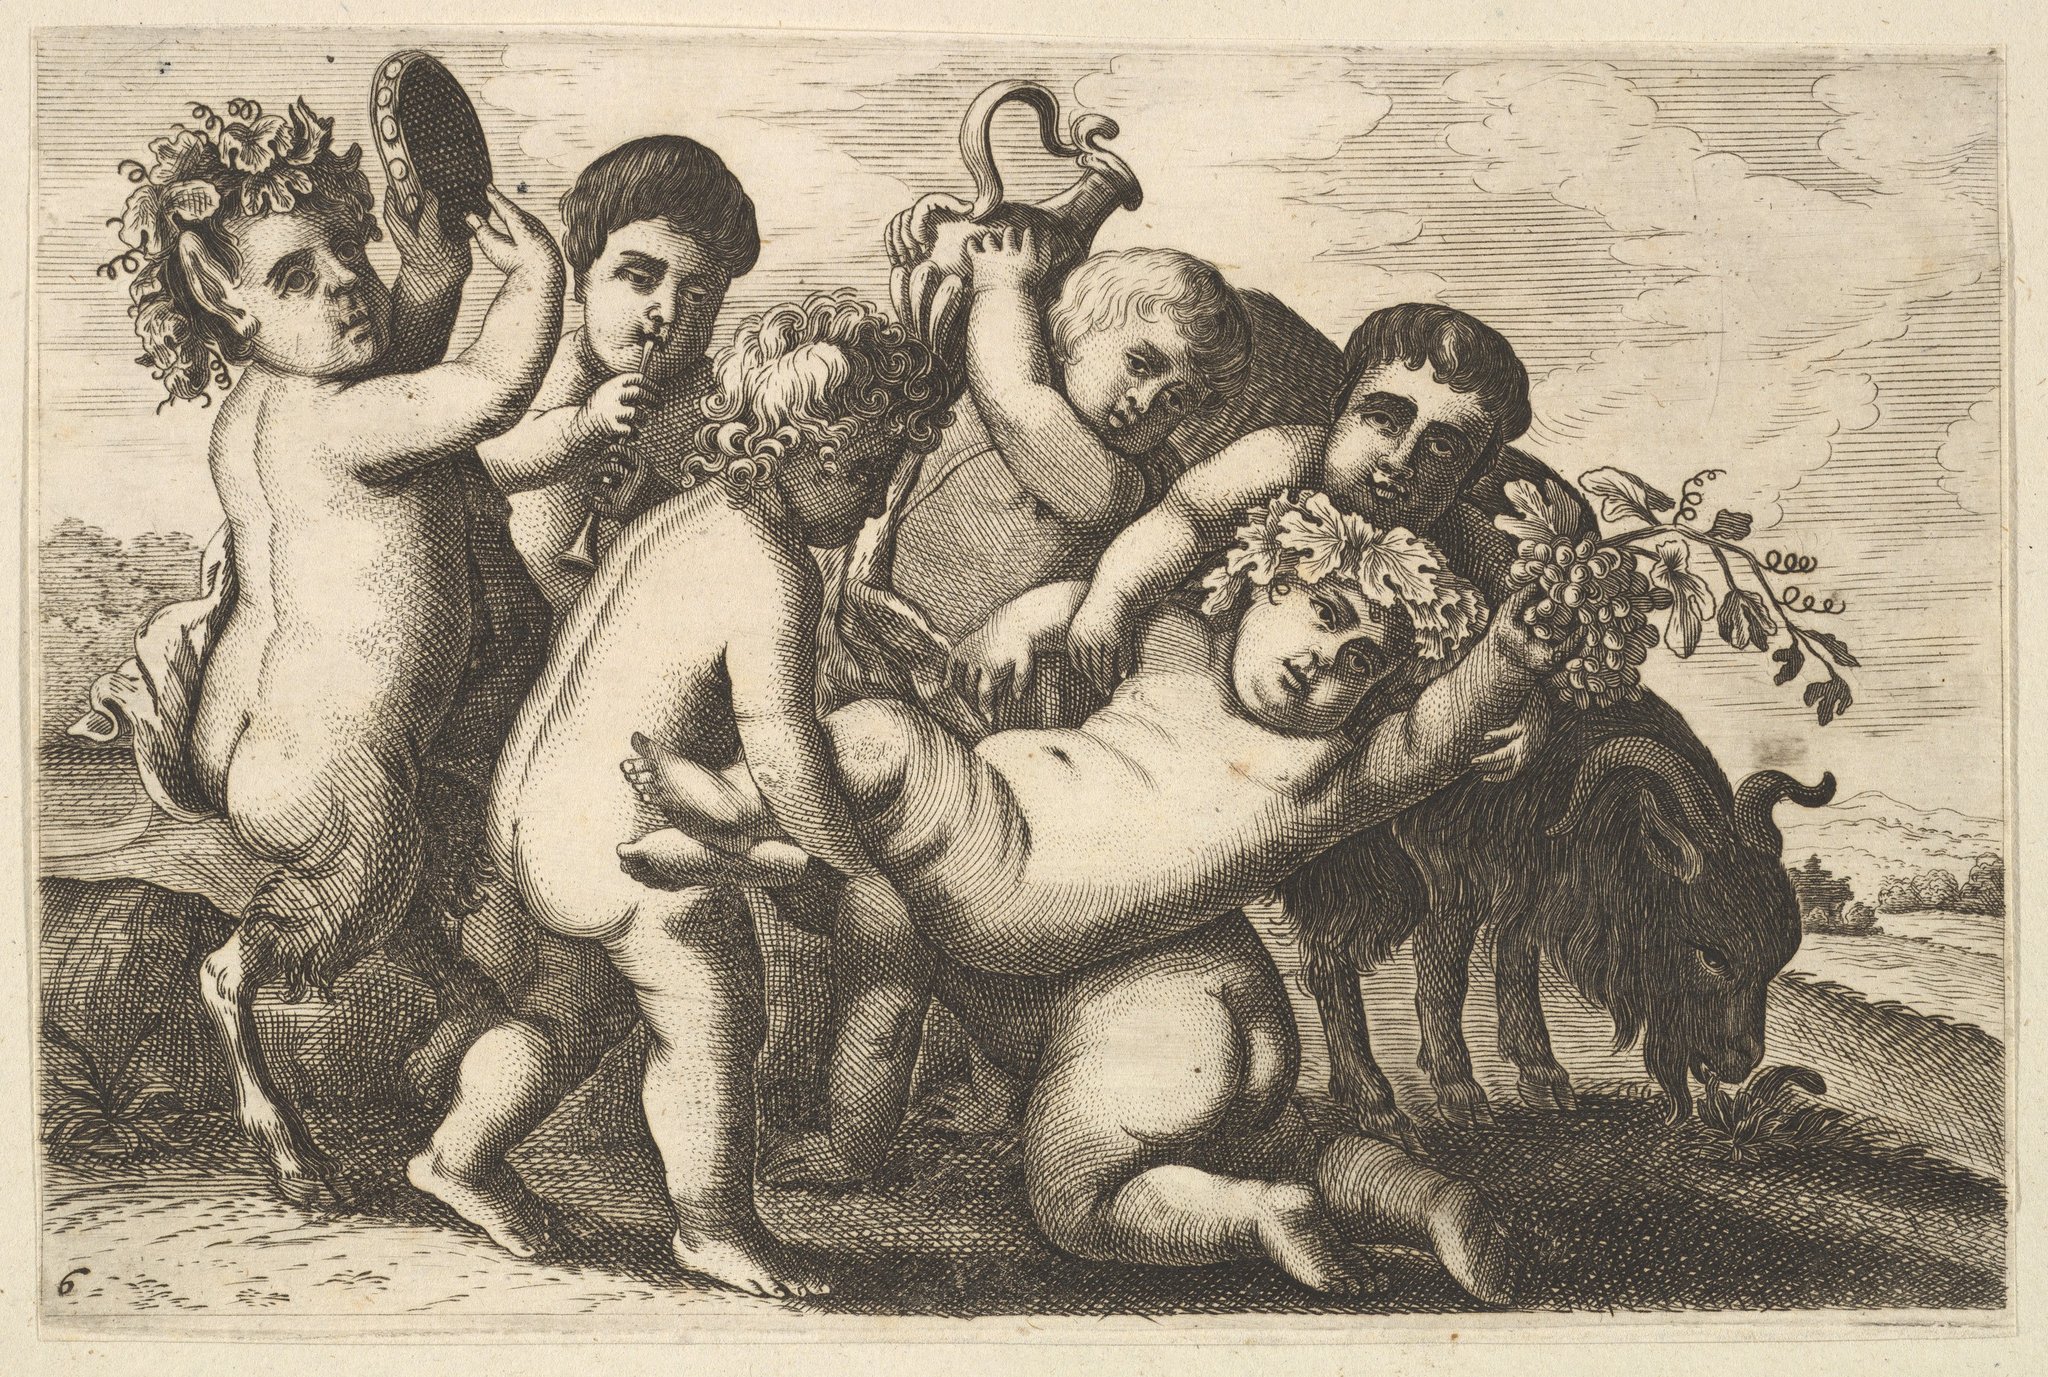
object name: print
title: Five boys, two satyrs, and a goat (copy in reverse)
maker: wenceslaus hollar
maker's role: artist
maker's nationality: bohemian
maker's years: 1607-1677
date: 1601-1700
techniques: engraving, etching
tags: boys,male nudes,satyrs,goats